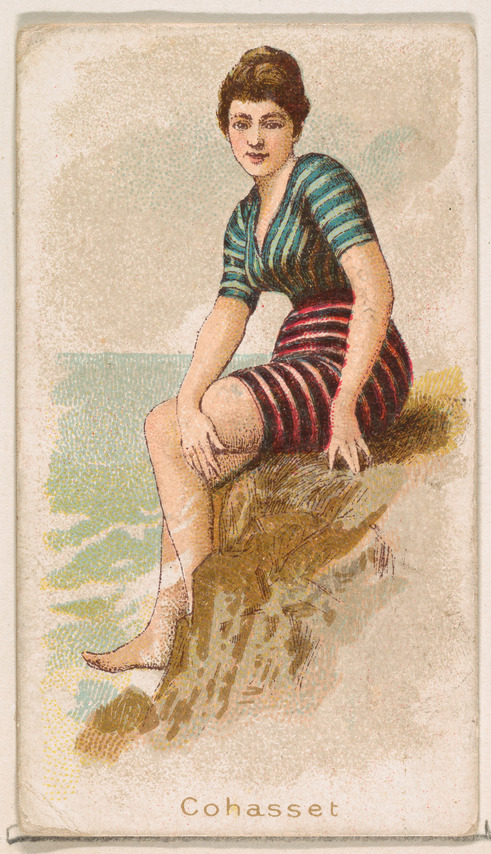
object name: print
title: Cohasset, from the Fancy Bathers series (N187) issued by Wm. S. Kimball & Co.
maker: william s. kimball & company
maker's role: publisher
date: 1889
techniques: color lithograph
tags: women